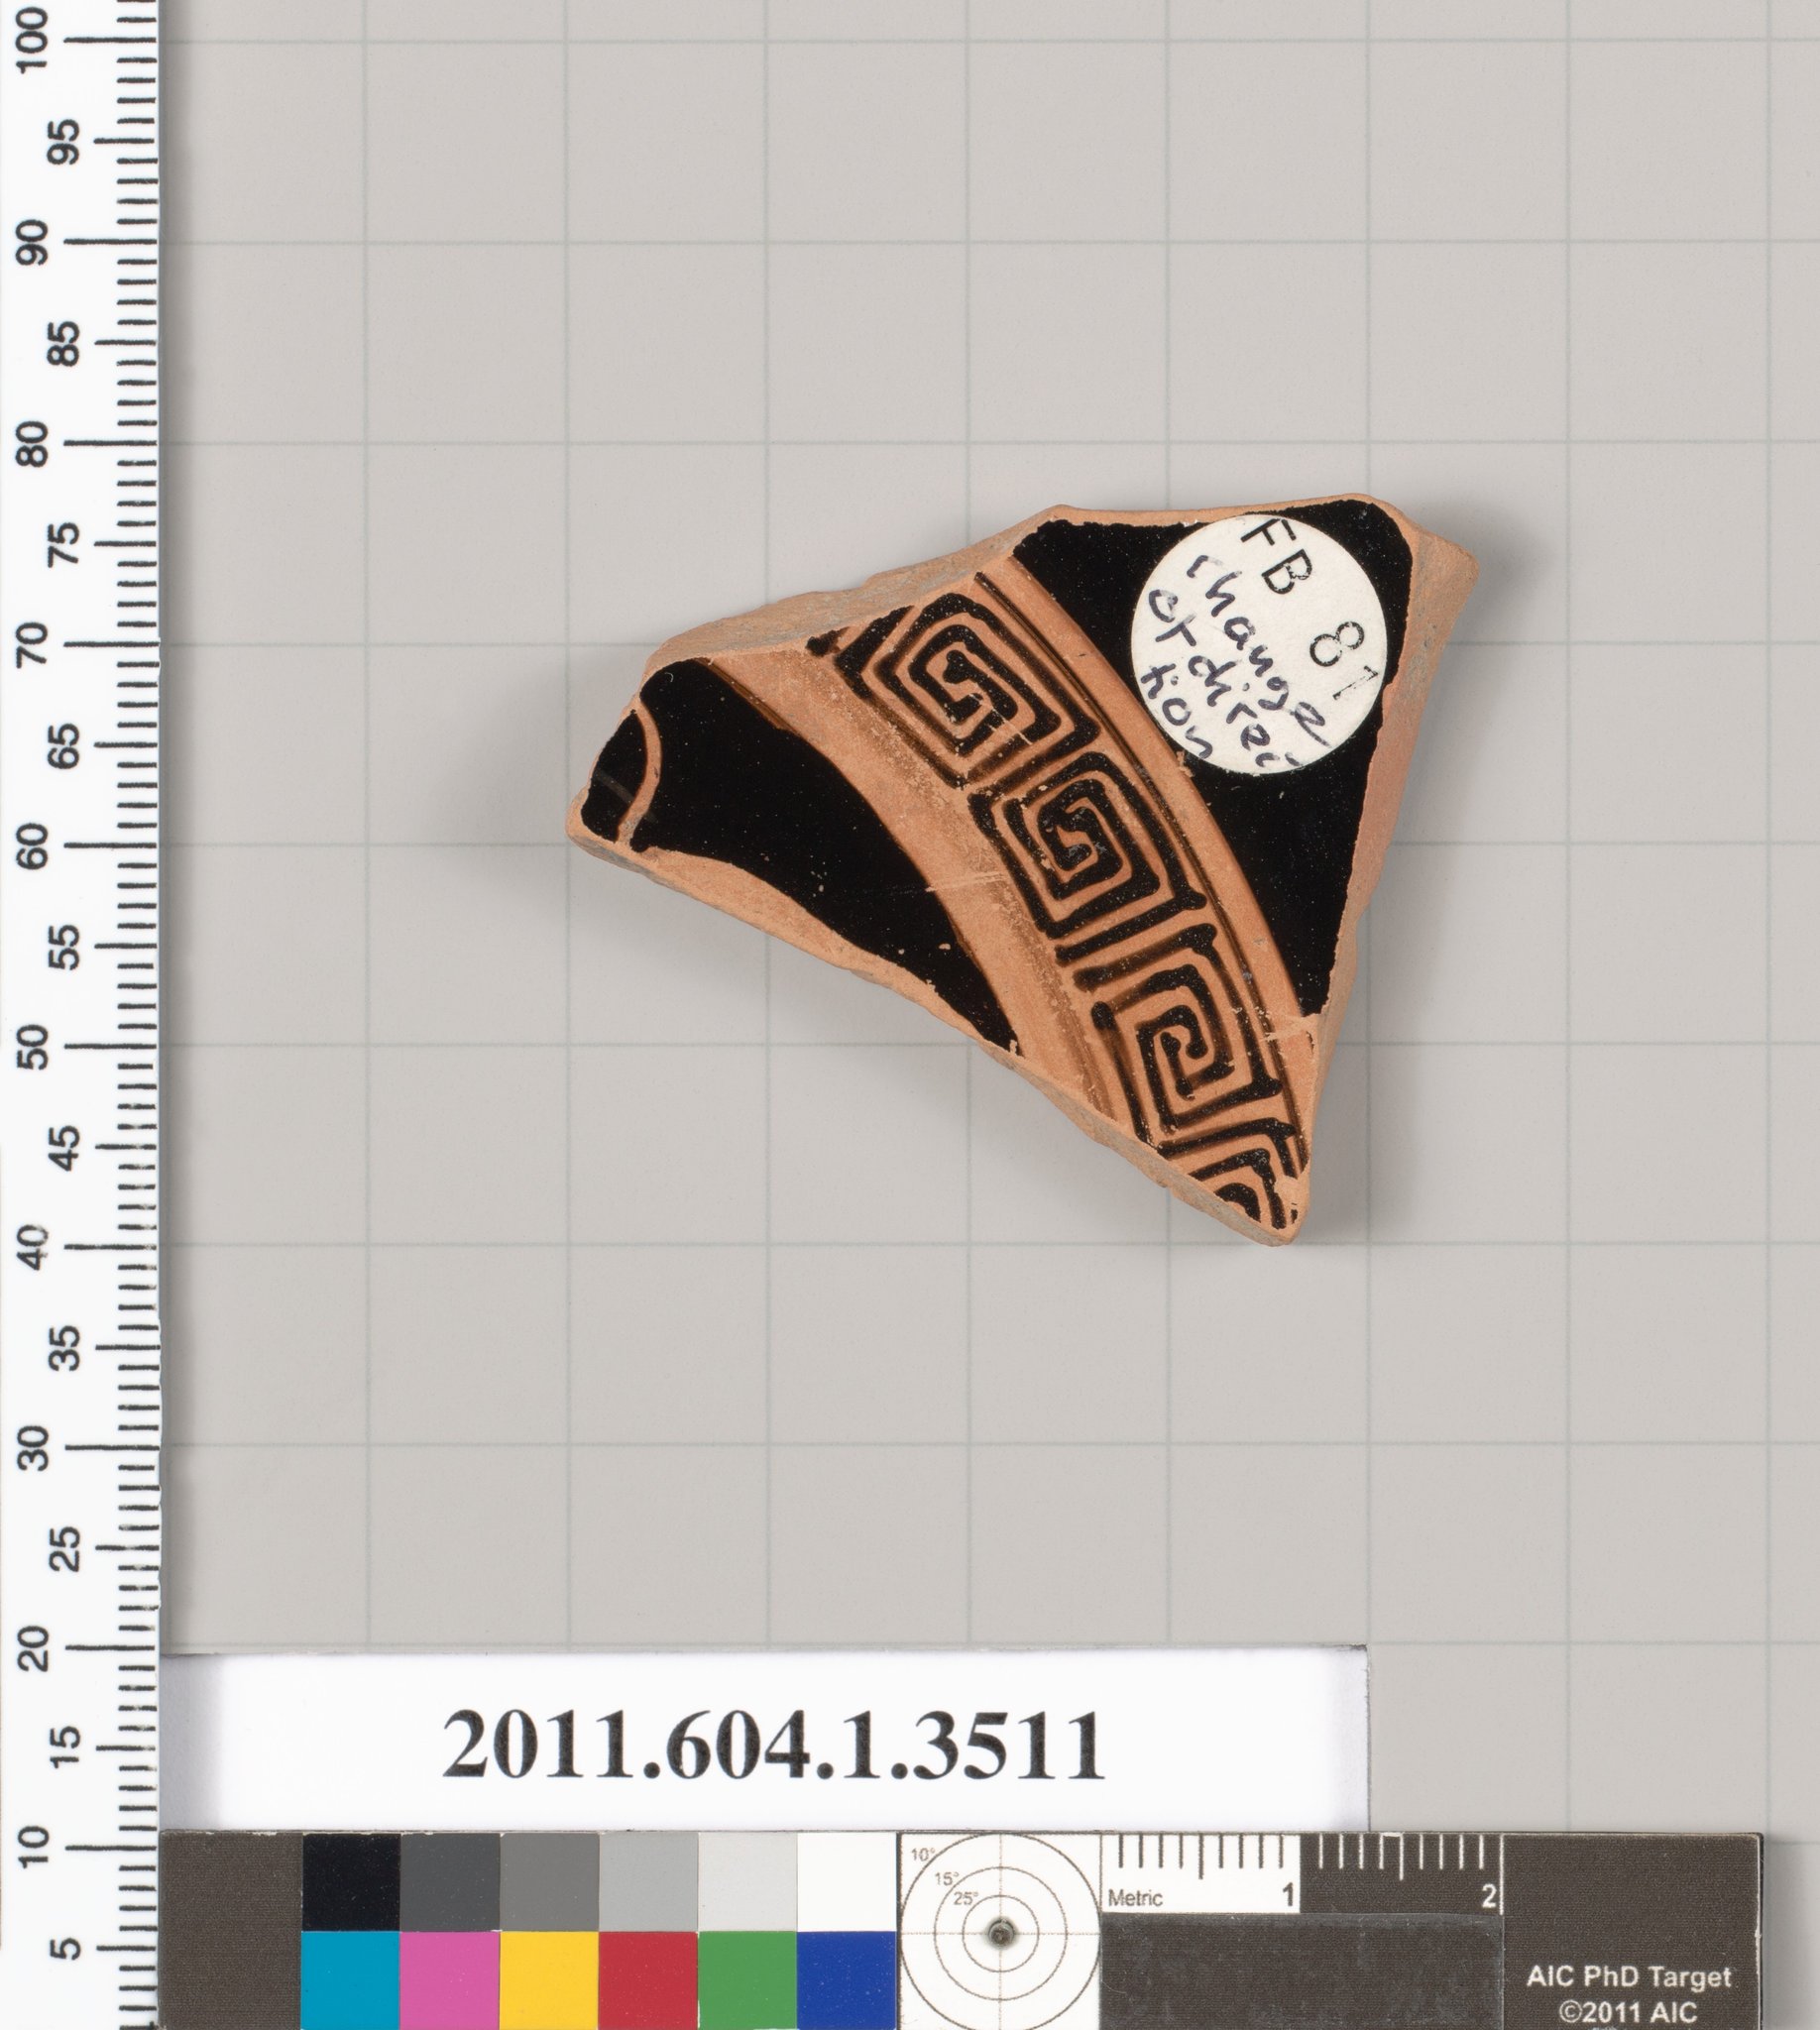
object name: kylix fragment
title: Terracotta fragment of a kylix (drinking cup)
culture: greek, attic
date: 475-451 BCE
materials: terracotta